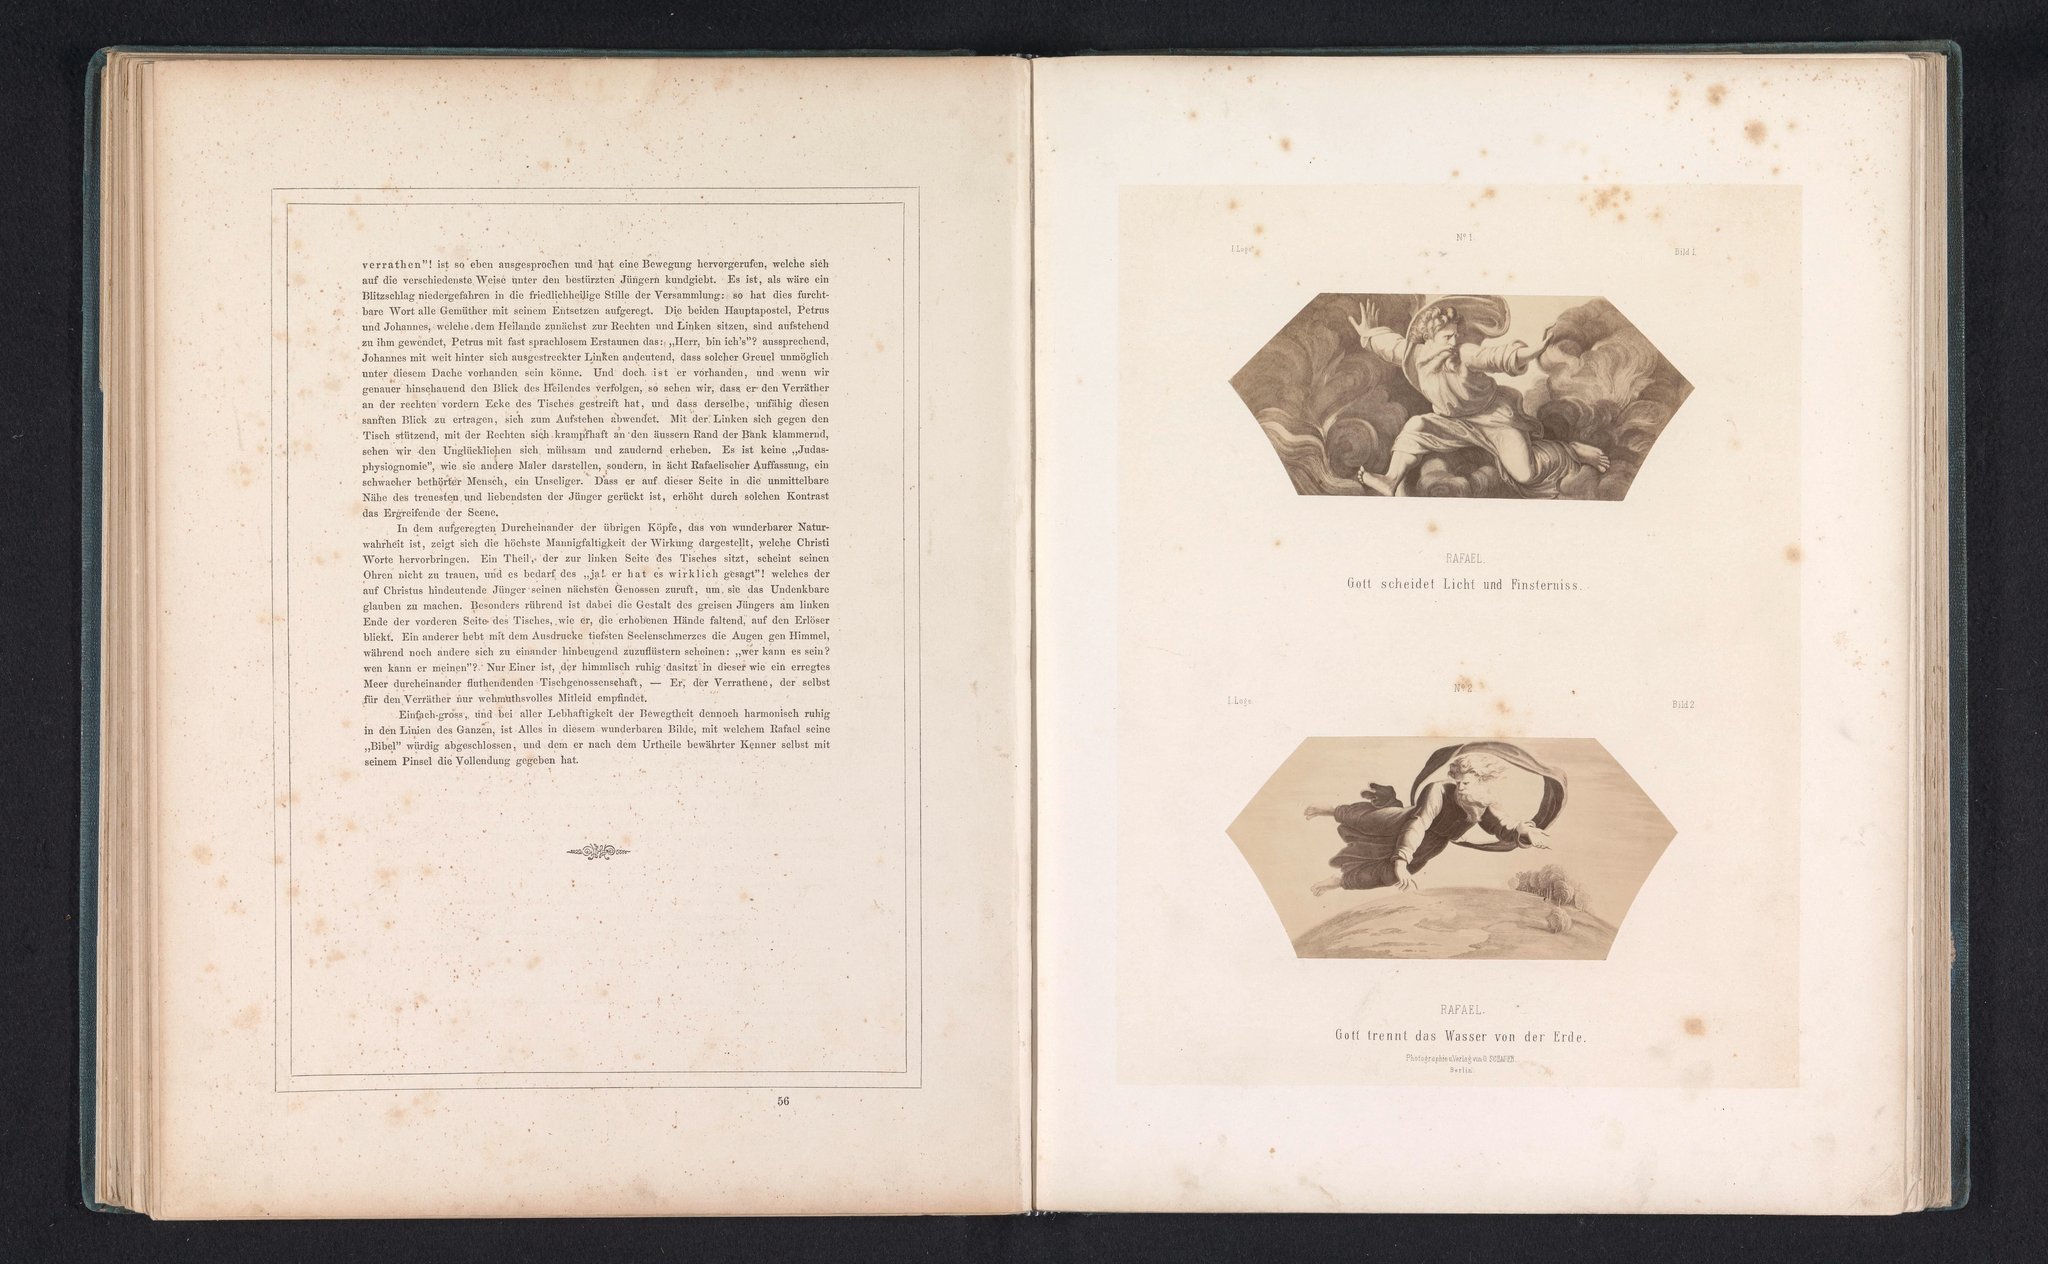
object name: photograph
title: Fotoreproducties van prenten naar fresco's met voorstellingen van god door Rafaël voor de loggia's in het Vaticaan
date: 1851-1861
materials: photographic support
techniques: albumen print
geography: berlin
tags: creation of the firmament and division of the waters above and below it, division of light and darkness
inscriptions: number: ‘Bild 1. Bild 2. I. Loge’